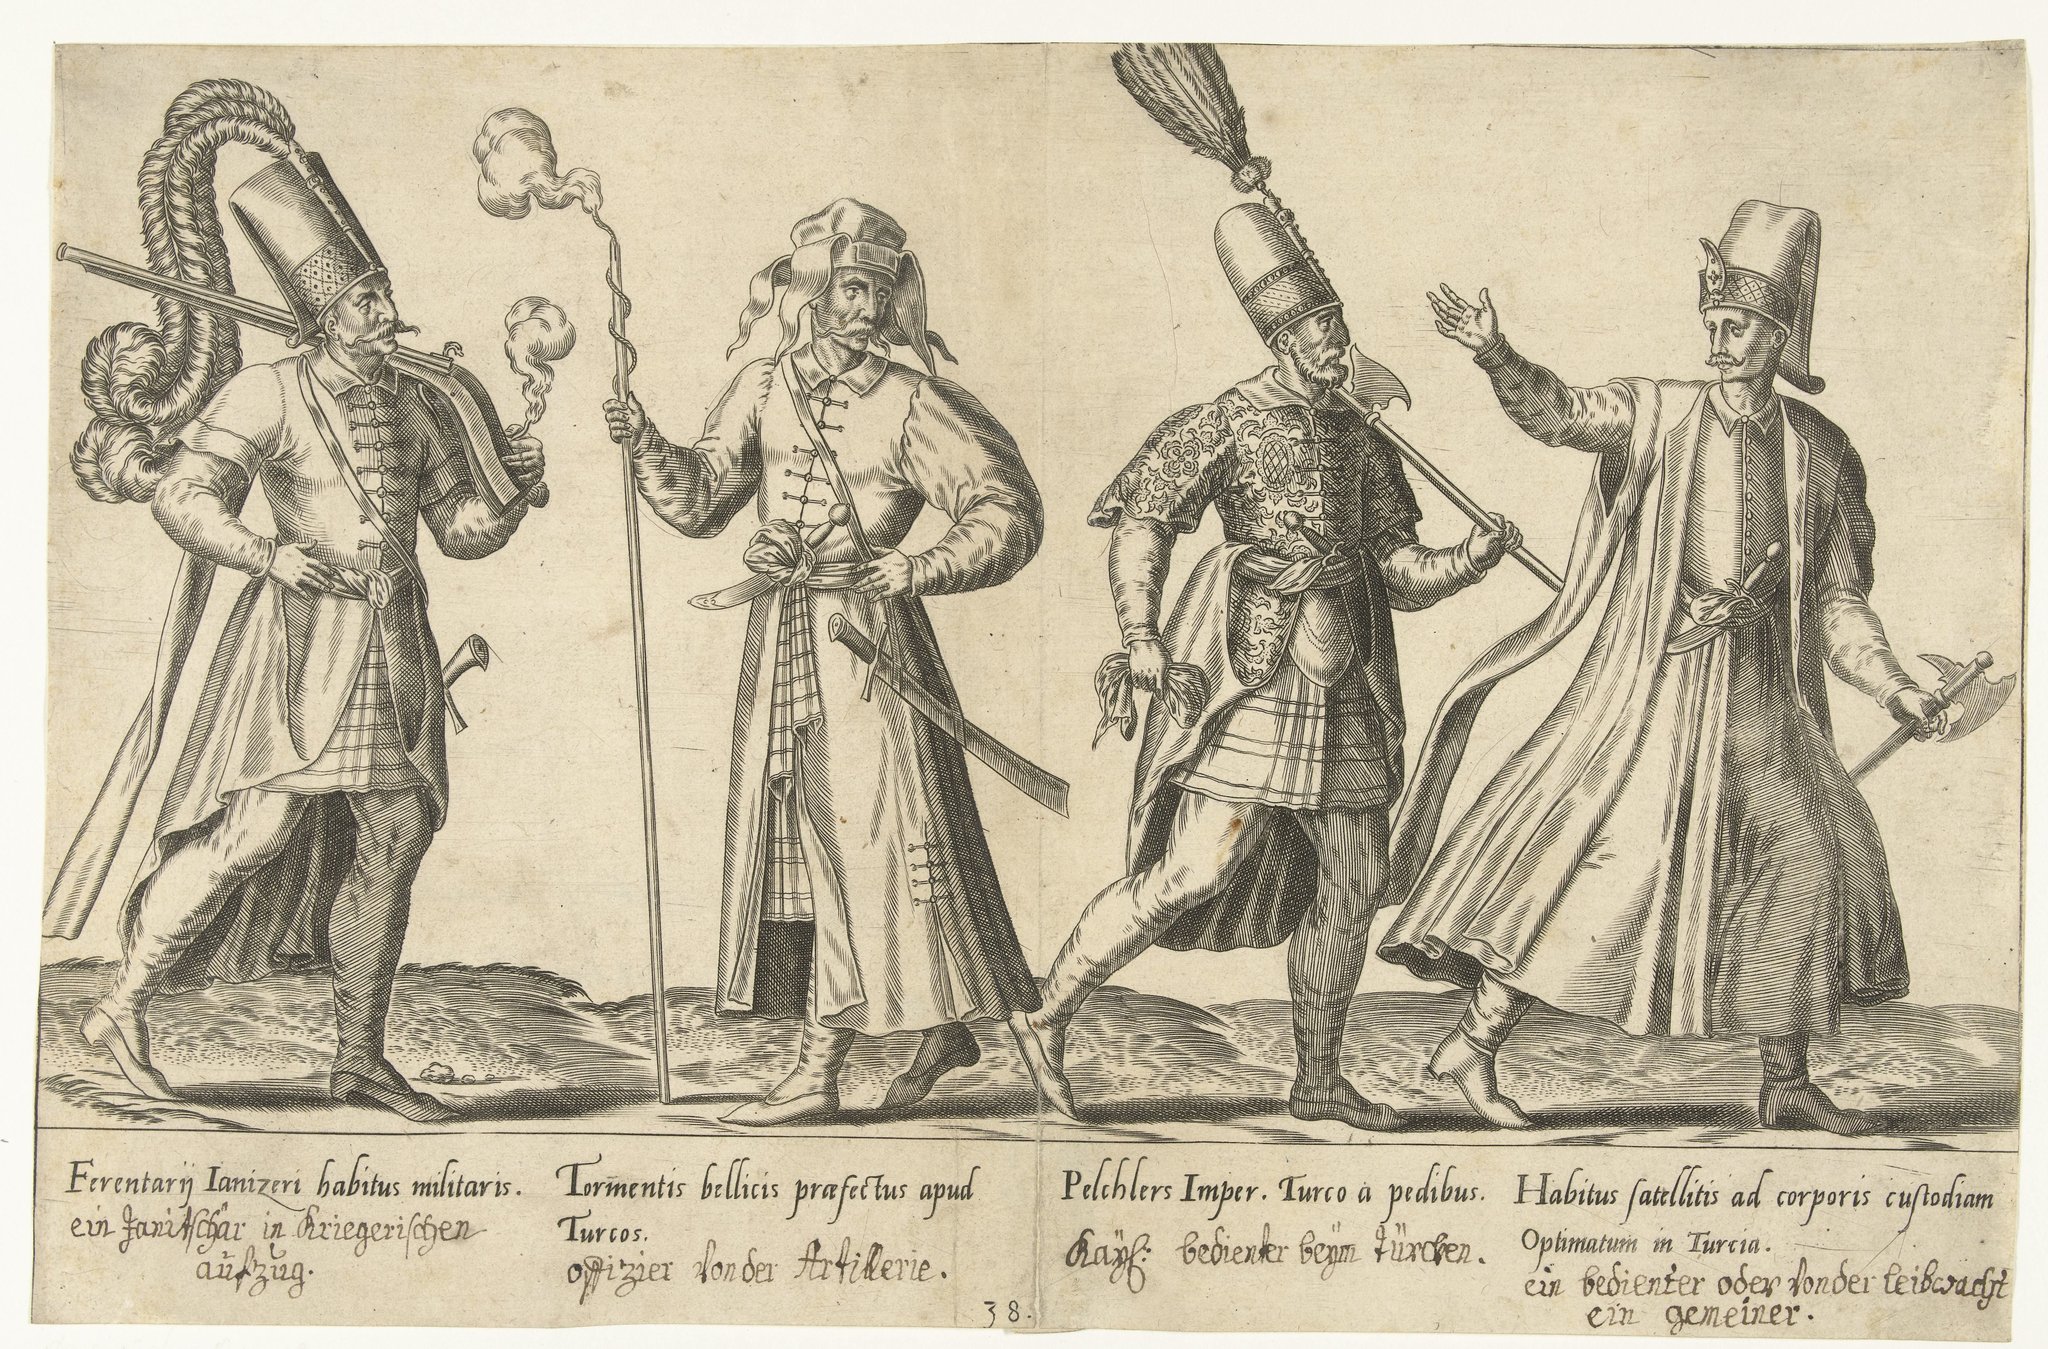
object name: costume print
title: Kleding van Ottomaanse soldaten rond 1580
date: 1581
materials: paper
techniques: engraving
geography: antwerp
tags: asiatic races and peoples: turks, clothes, costume (+ men's clothes), warfare; military affairs (+ infantry), warfare; military affairs (+ artillery), body-guard of ruler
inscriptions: collector's mark: Lugt 2228, caption: ‘ein Janischär in kriegerischen aufzug. Offizier soder Artillerie. Räuf bediender beïm Türcken. ein bediender oder sonder Leibwacht ein gemeiner.’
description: Prent uit een boek over zestiende-eeuwse kleding rond 1580. Vier soldaten uit het Ottomaanse leger. Alle vier zijn anders gekleed. Van links naar rechts: een janitsaar met een geweer, een artillerie-specialist met een lont, een infanterist met een bijl en een met een bijl gewapende lijfwacht. De prent heeft een Latijns onderschrift.